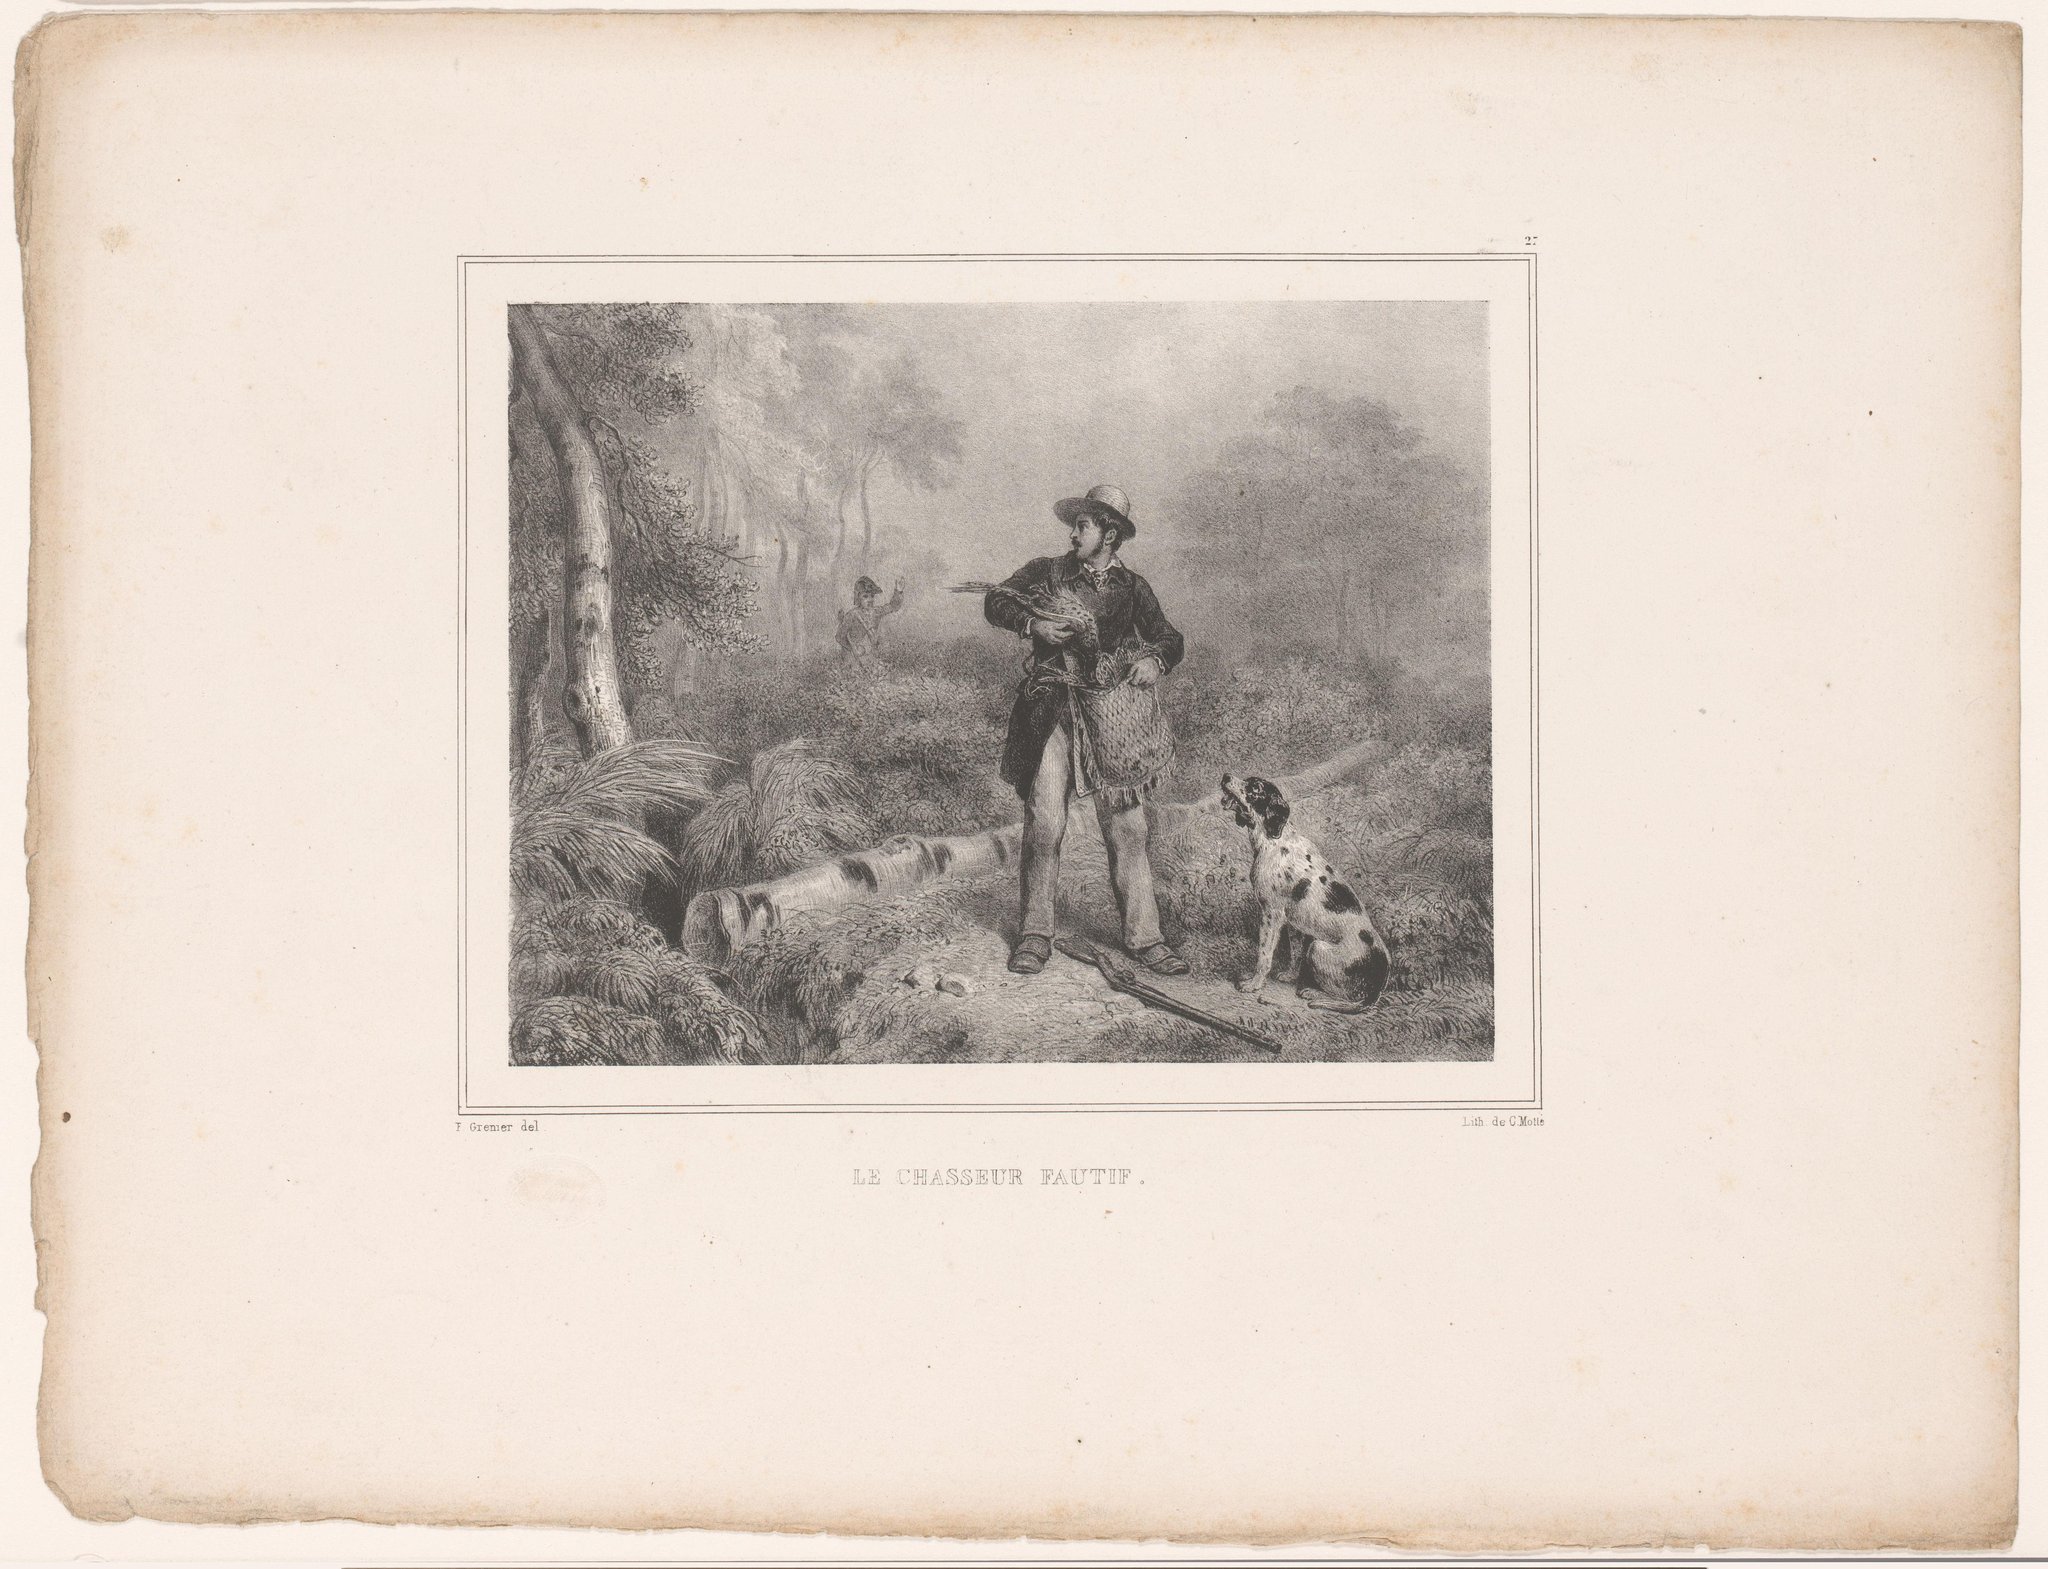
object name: print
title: Stroper wordt betrapt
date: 1819-1836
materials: paper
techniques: lithograph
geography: paris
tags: poacher, forest, wood, arrest (of criminal)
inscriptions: collector's mark: Lugt 2228a, check stamp: Lugt 1828c